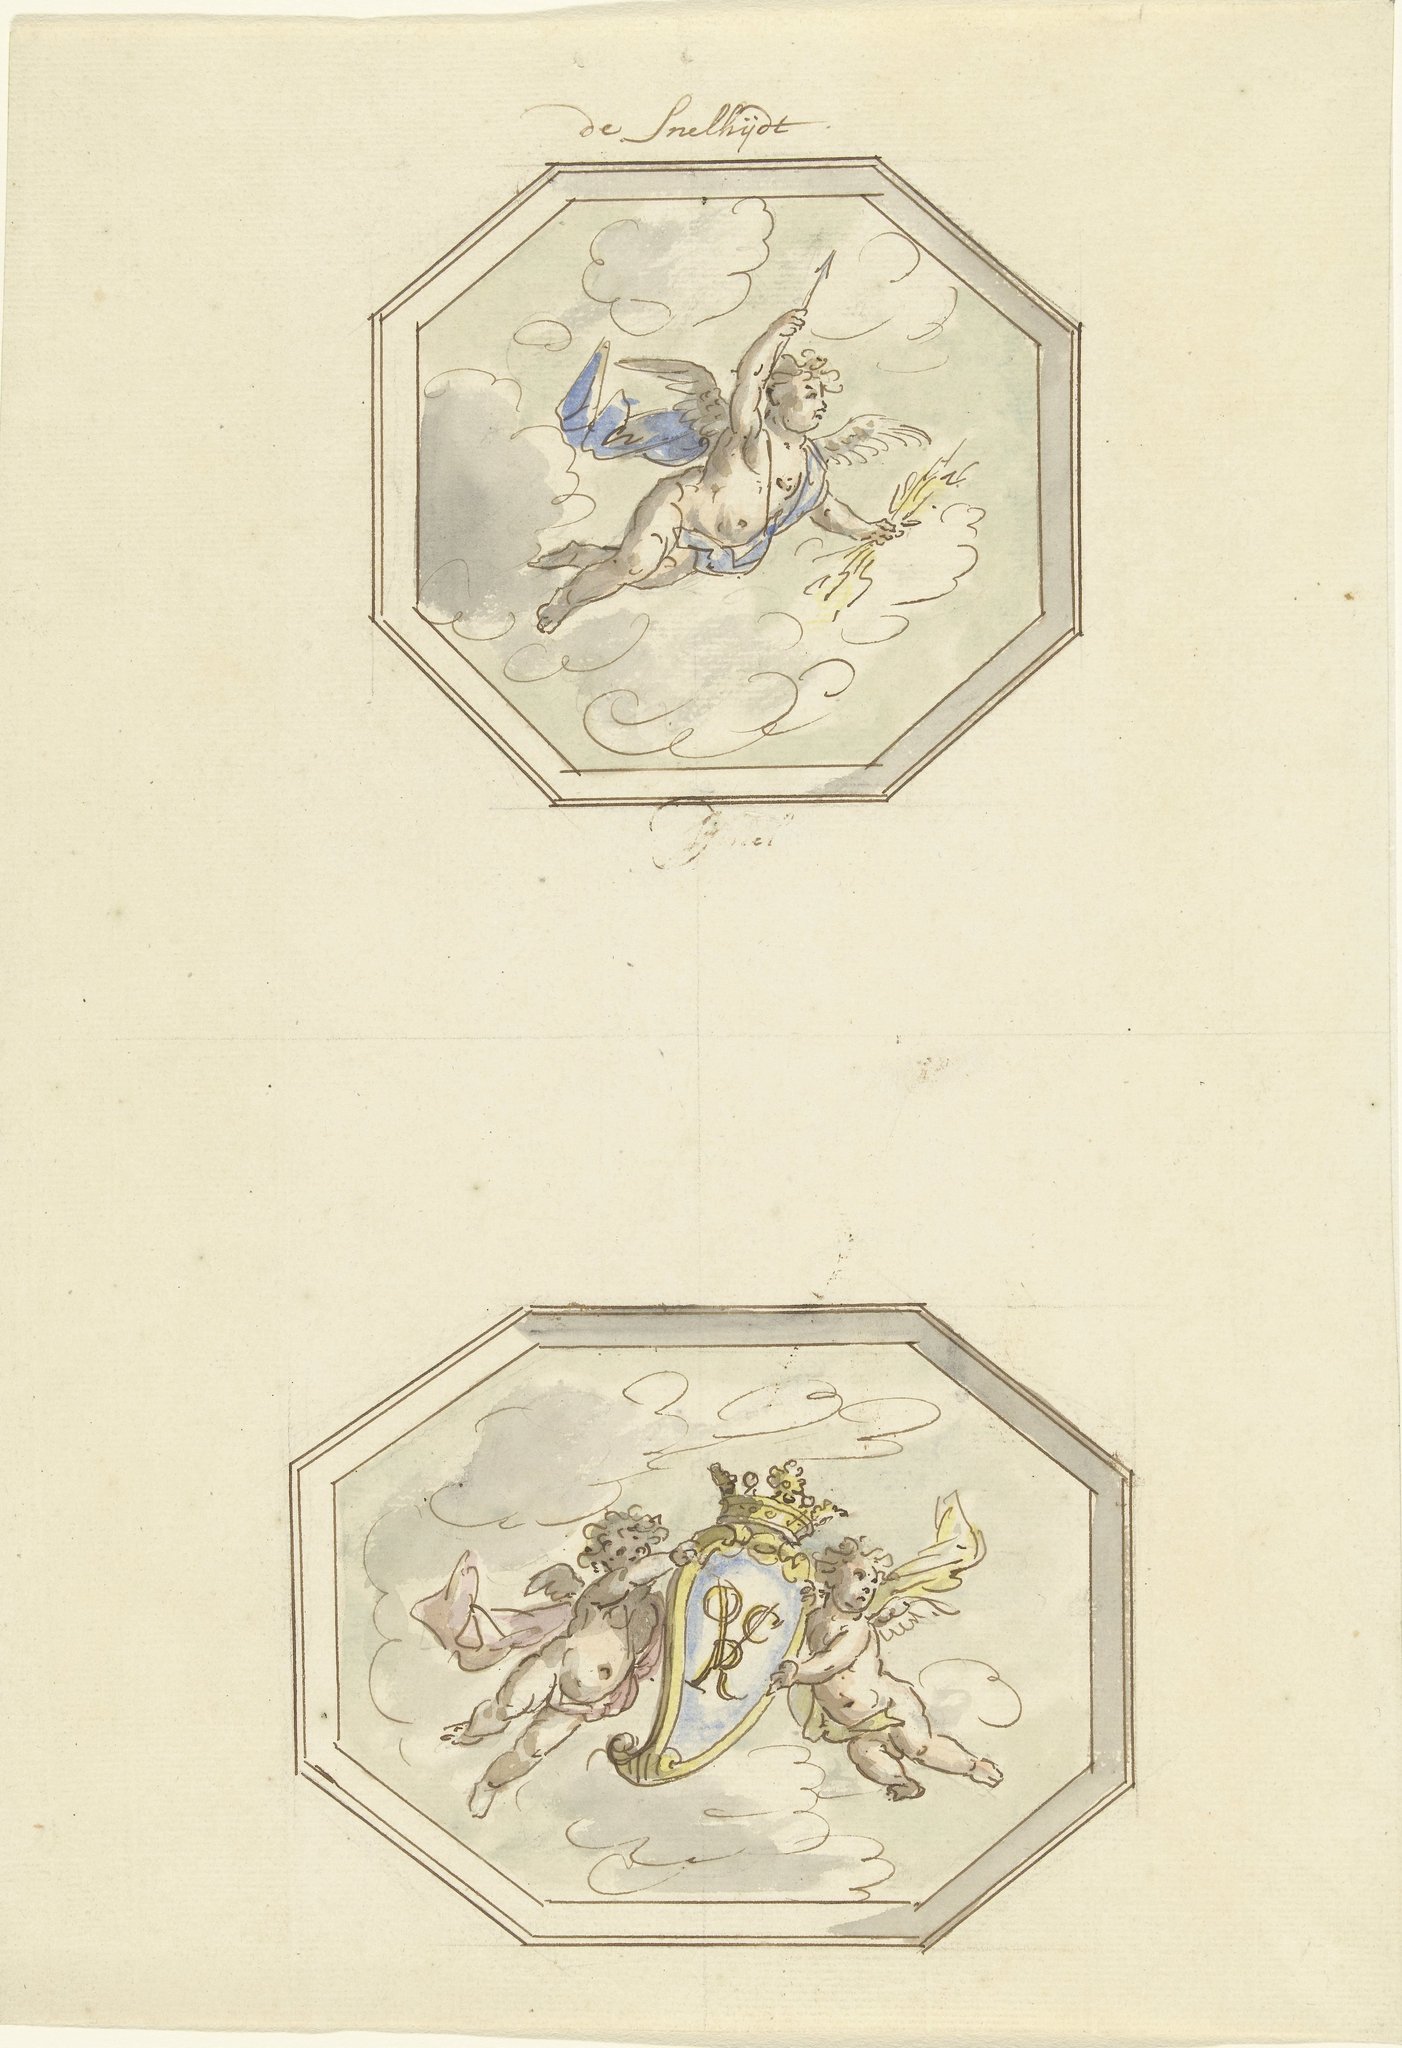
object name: drawing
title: Twee ontwerpen voor plafondschilderingen: de Snelheid en putti met wapenschild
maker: elias van nijmegen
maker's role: draughtsman, painter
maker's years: 1667-1755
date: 1677-1755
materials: ink, paper, pencil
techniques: brush, pen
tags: swiftness, speed; 'agilità', 'celerità', 'velocità' (ripa) (+ abstract concept represented by child), armorial bearing, heraldry